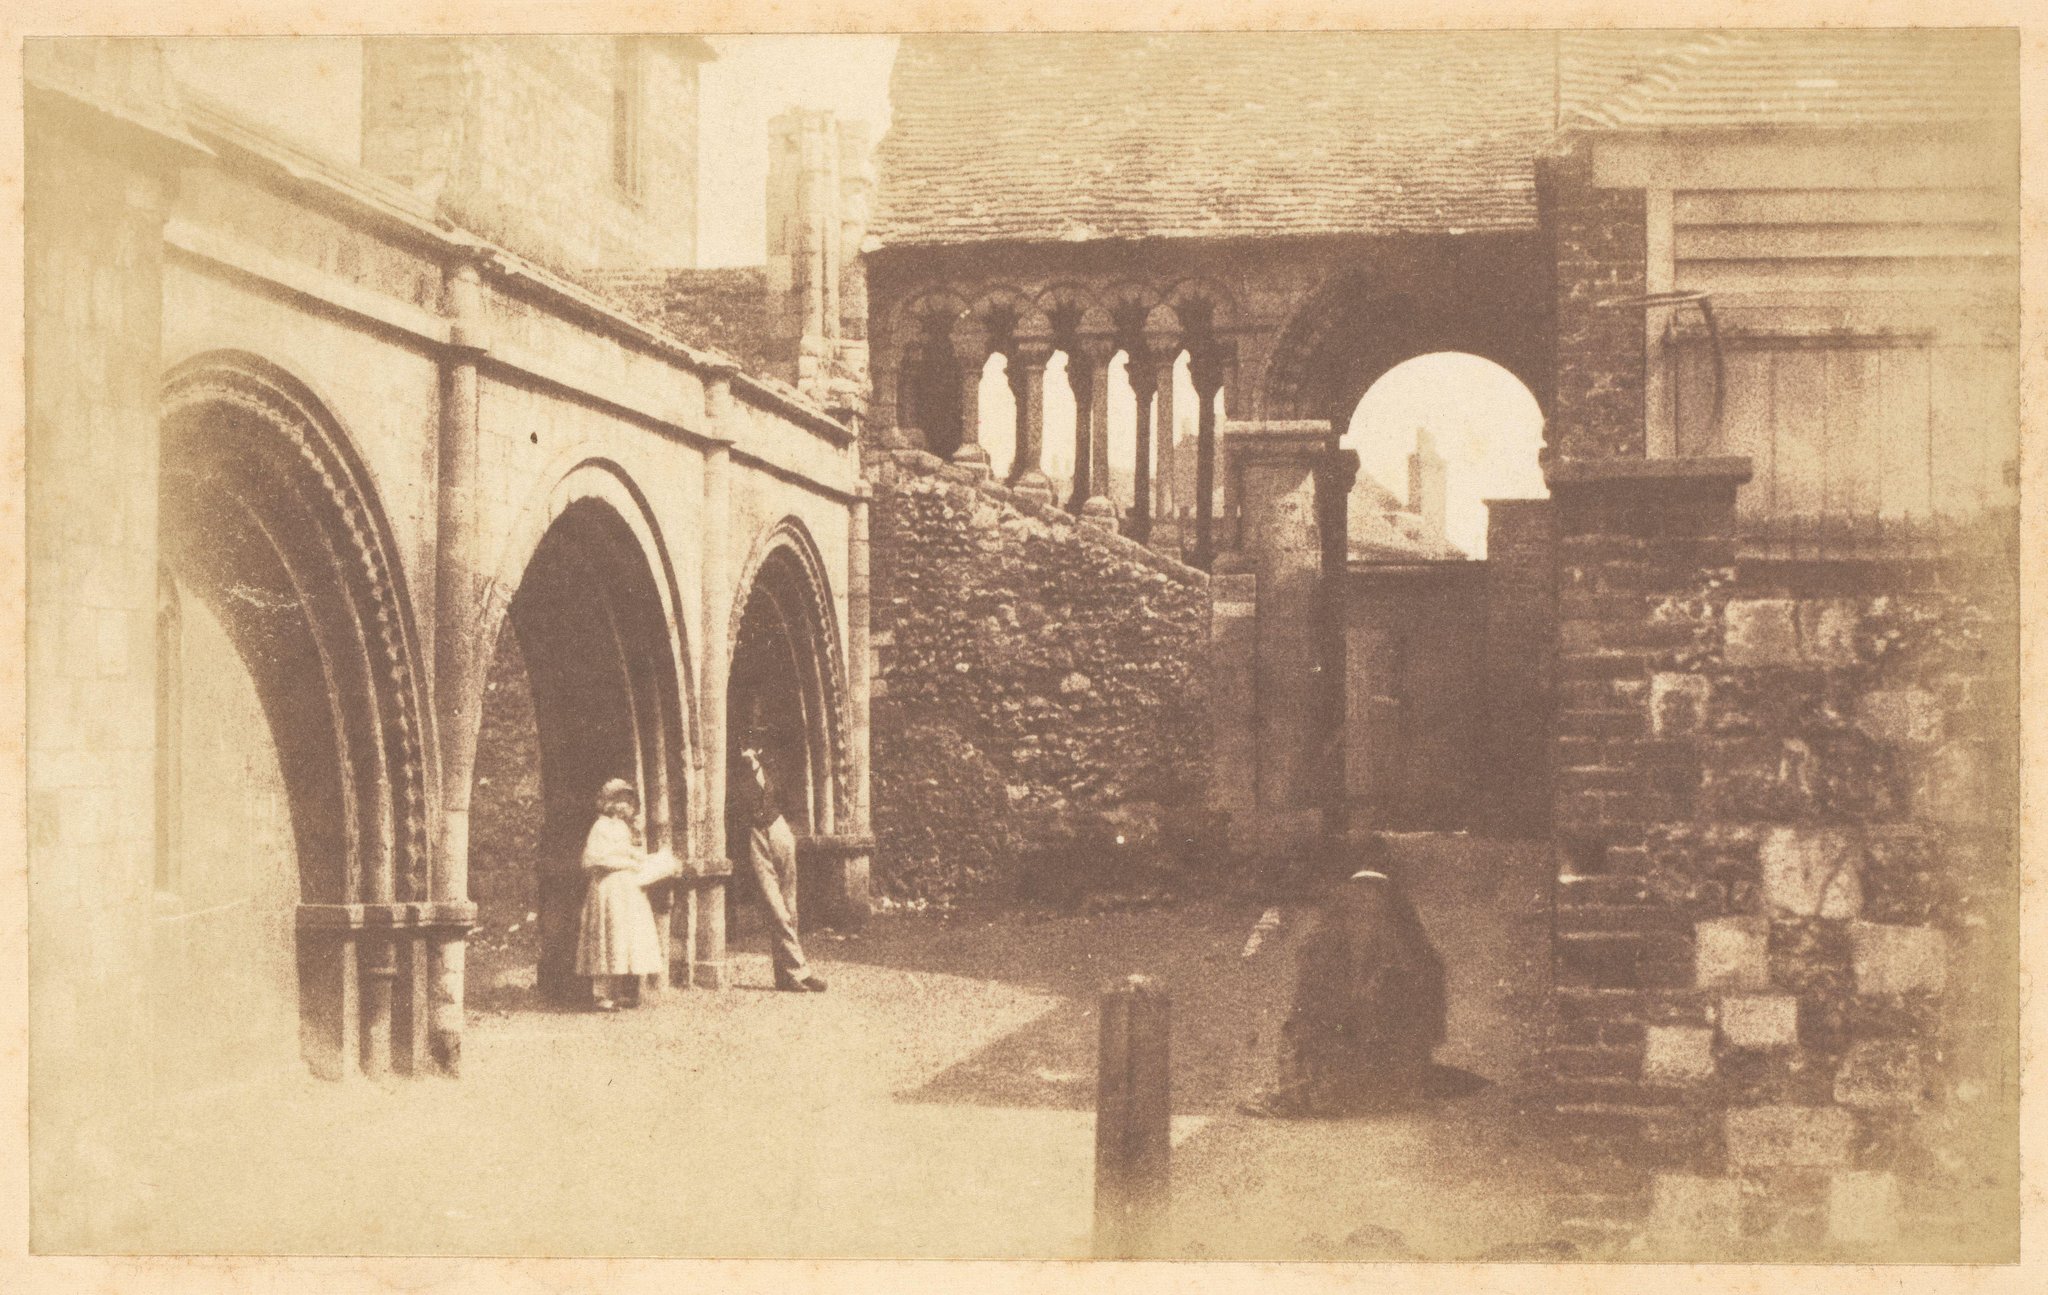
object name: photograph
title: Canterbury 'Louisa Helps'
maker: john muir wood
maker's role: publisher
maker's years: 1805-1892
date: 1847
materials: cardboard, photographic support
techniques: salted paper print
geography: canterbury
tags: street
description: In de zomer van 1847 vertrok de Schotse musicus en amateurfotograaf John Muir Wood (1805-1892) via York en Londen naar het vaste land van Europa. Daar bezocht hij enkele Belgische steden, zoals Gent, Mechelen en Brussel, maar vermoedelijk ook Duitsland. Hoewel Woods dagboek van deze reis ophoudt in Brussel, waar hij op 8 augustus het Paleis van Justitie fotografeerde, zijn er ook foto's van Keulen, Heidelberg, Nürnberg en München in zijn fotografische nalatenschap. Over Woods werkzaamheden als fotograaf is bijzonder weinig bekend. Zijn Europese reis van 1847 is de enige keer dat hij melding maakt van zijn fotografische activiteiten. Zo weten we niet wanneer Wood is begonnen met fotograferen, noch van wie hij het zou kunnen hebben geleerd. In ieder geval bewoog hij zich in kringen die hem vrij makkelijk met het medium in contact moeten hebben gebracht. Wellicht kende hij David Octavius Hill en Robert Adamson, die tussen 1843 en 1847 een studio in zijn geboortestad Edinburgh hadden. Wood heeft een oeuvre van zo'n 900 foto's nagelaten die ongeveer in de periode 1845-1855 zijn gemaakt. Merendeels pittoreske en romantisch getinte landschappen, stadsgezichten en portretten die worden gekenmerkt door een contrastrijke en sfeervolle lichtval. De foto die Wood in Canterbury maakte doet zelfs mysterieus aan: Wat doet de vrouw rechts in de schaduw? En wat betekent de annotatie 'Louisa Helps' als deze tenminste origineel is? Het is goed mogelijk dat Wood deze foto in 1847 maakte op weg naar het continent. De vrij hoge lichtval kan duiden op een zomers tijdstip. Bovendien moet Wood door Kent gekomen zijn op weg naar de havenplaats Dover van waaruit hij vermoedelijk vertrokken is naar Oostende. Hoewel zijn dagboek Canterbury niet vermeldt, is het natuurlijk ook mogelijk dat hij op zijn terugweg de aartsbisschoppelijke stad heeft aangedaan. Source: Stevenson/Lawson/Gray 1988